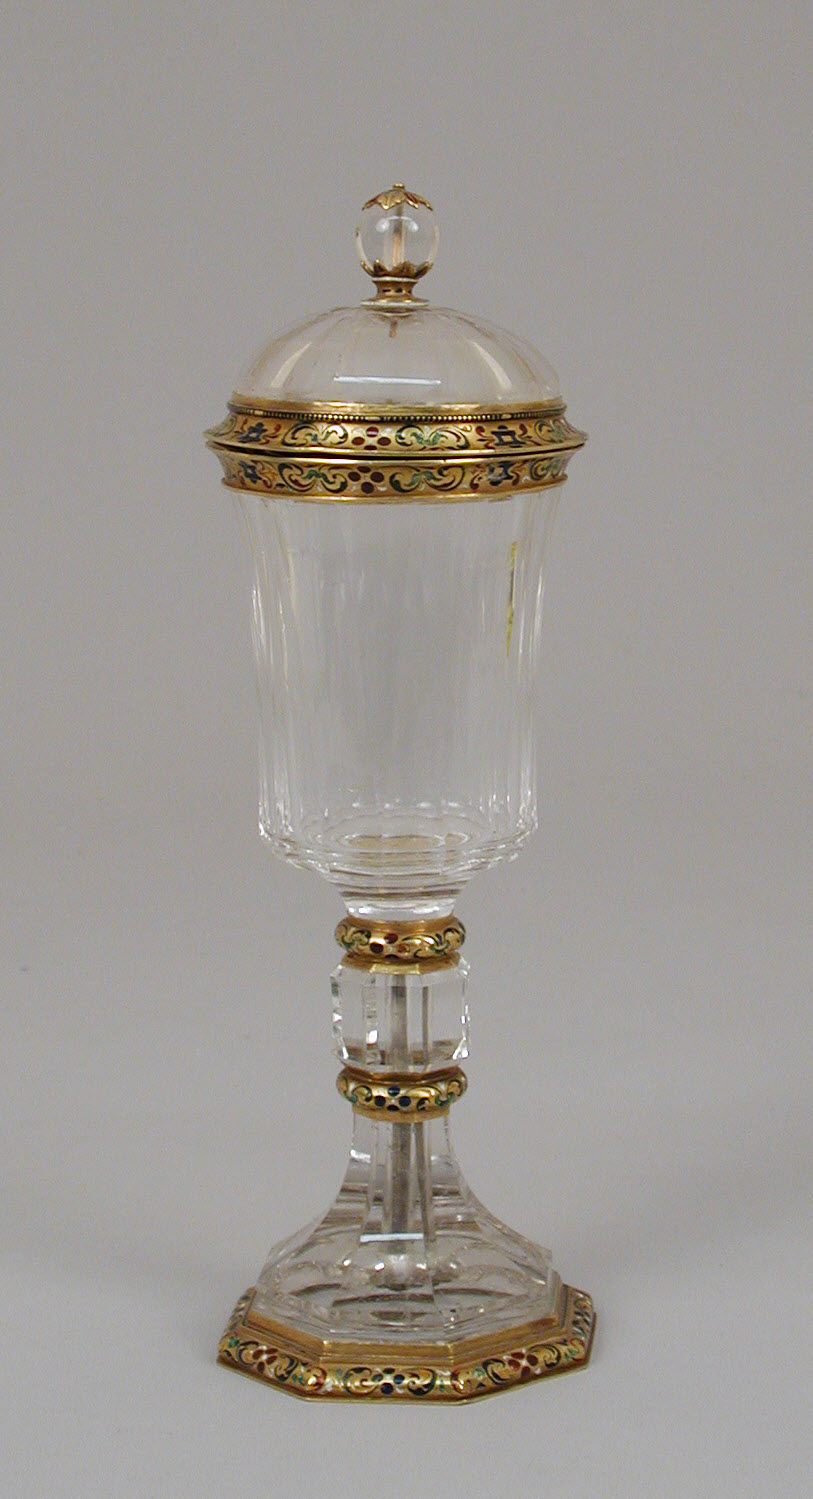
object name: standing cup with cover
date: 1601-1700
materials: enamel, gold, quartz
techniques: enamel